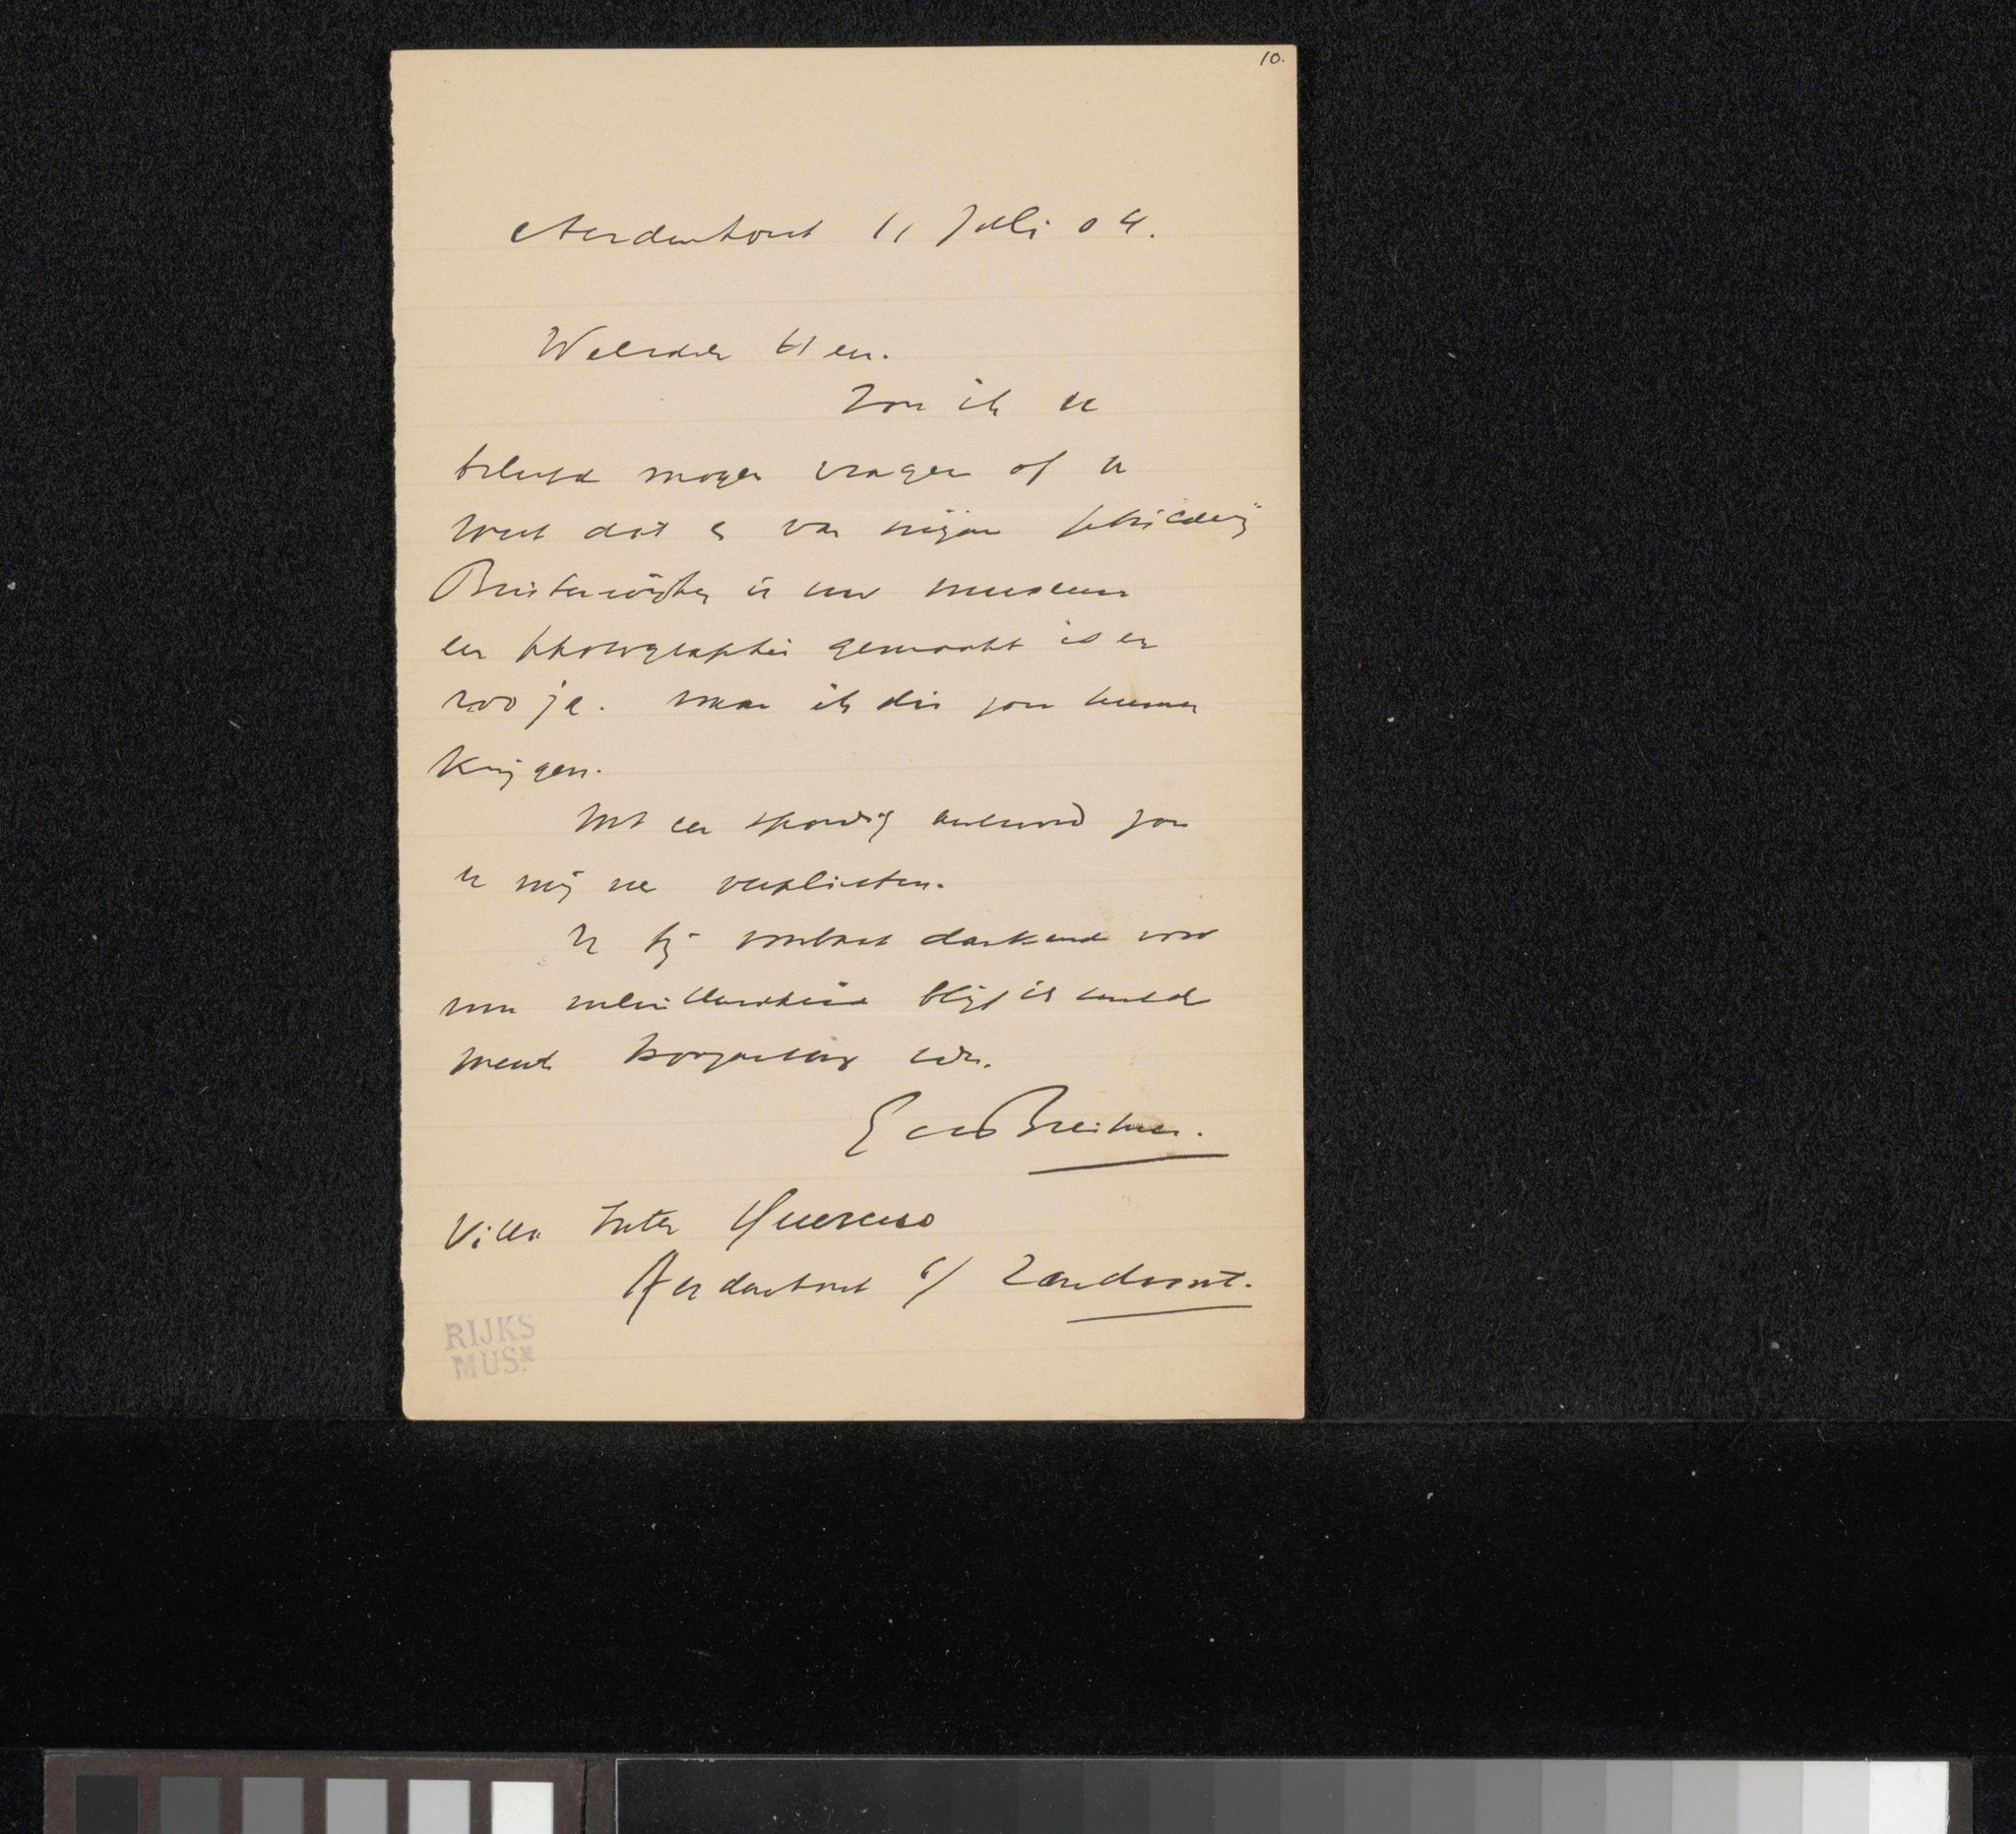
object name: letter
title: Brief aan Pieter Haverkorn van Rijsewijk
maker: george hendrik breitner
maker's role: draughtsman, painter, print maker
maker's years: 1857-1923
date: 1904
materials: ink, paper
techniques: pen, writing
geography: aerdenhout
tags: pieter haverkorn van rijsewijk, photography, cinematography, painting (including book-illumination, miniature-painting)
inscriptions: collector's mark: Lugt 2166